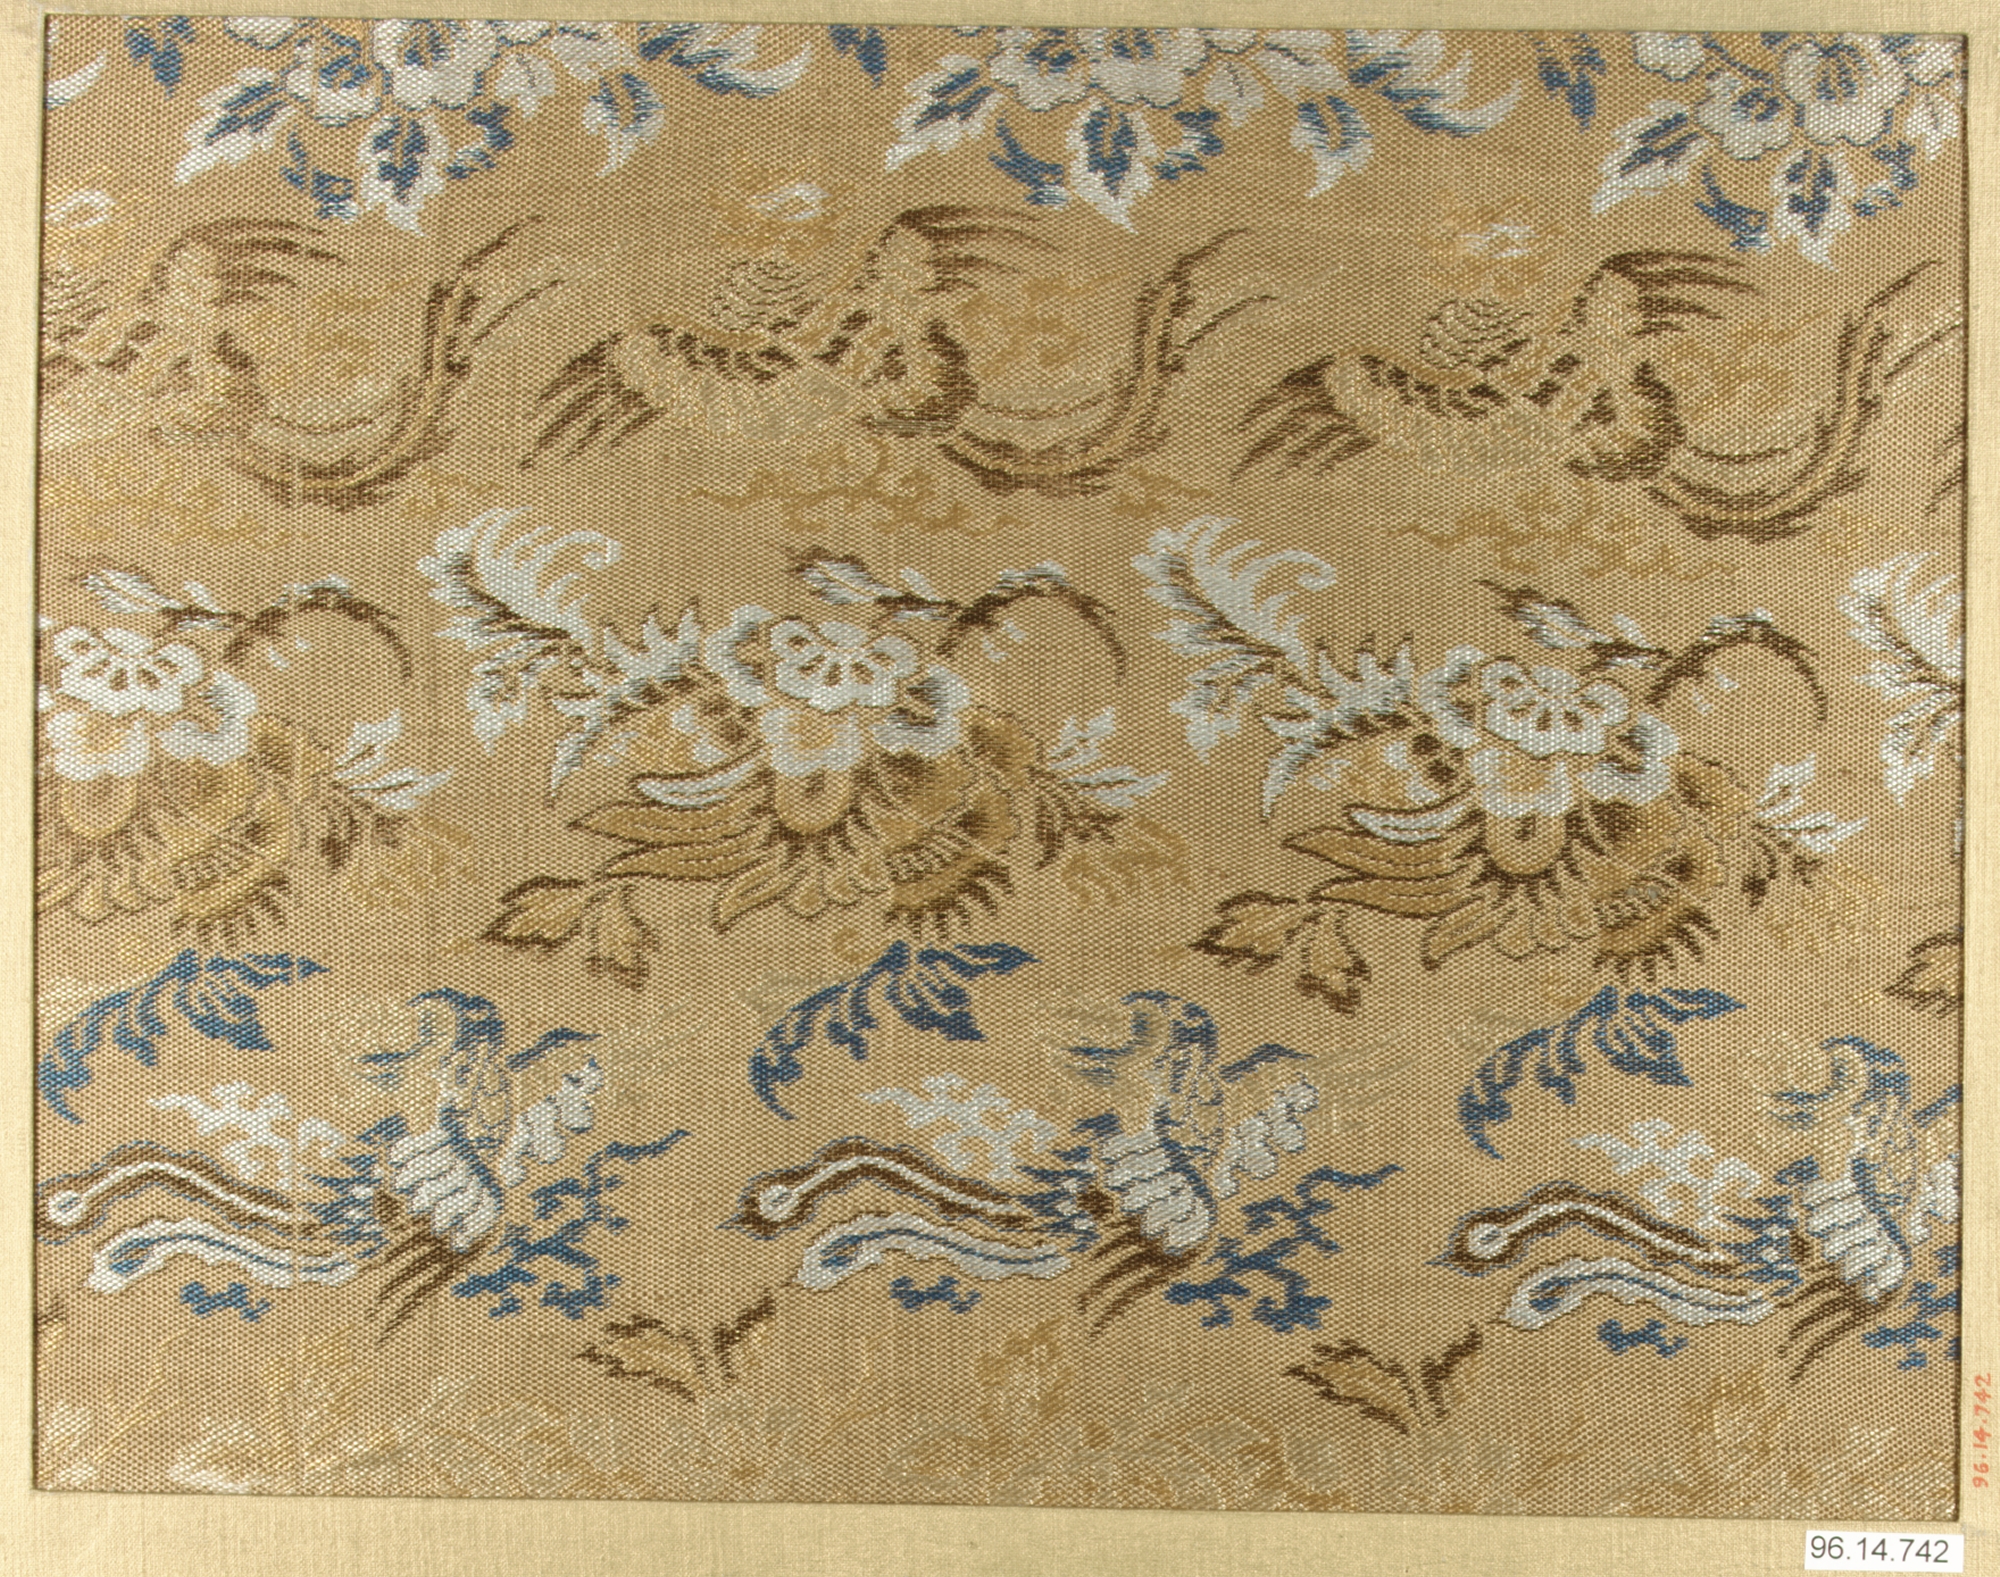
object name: piece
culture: japanese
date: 1701-1900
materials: silk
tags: flowers